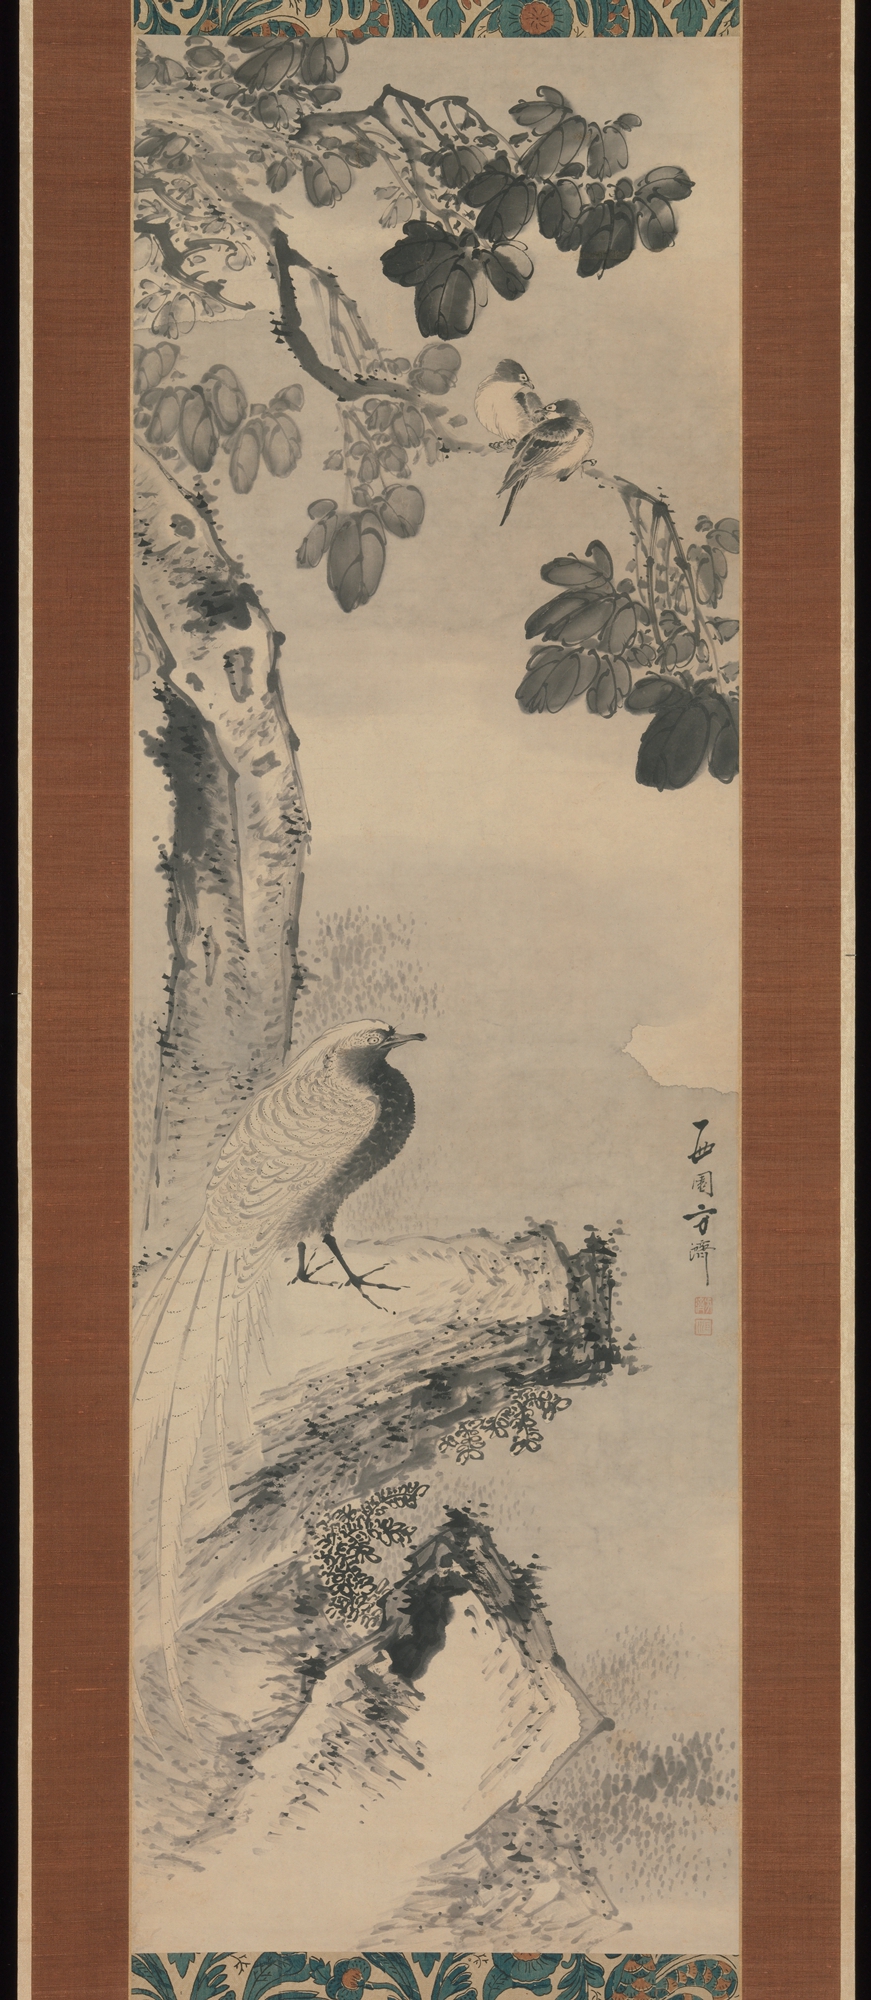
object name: hanging scroll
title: Pheasant beneath Paulownia Tree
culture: japanese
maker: saien hōsai (xiyua fangqi)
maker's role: artist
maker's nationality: chinese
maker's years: 1736-1795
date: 1701-1800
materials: ink, paper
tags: pheasants,trees